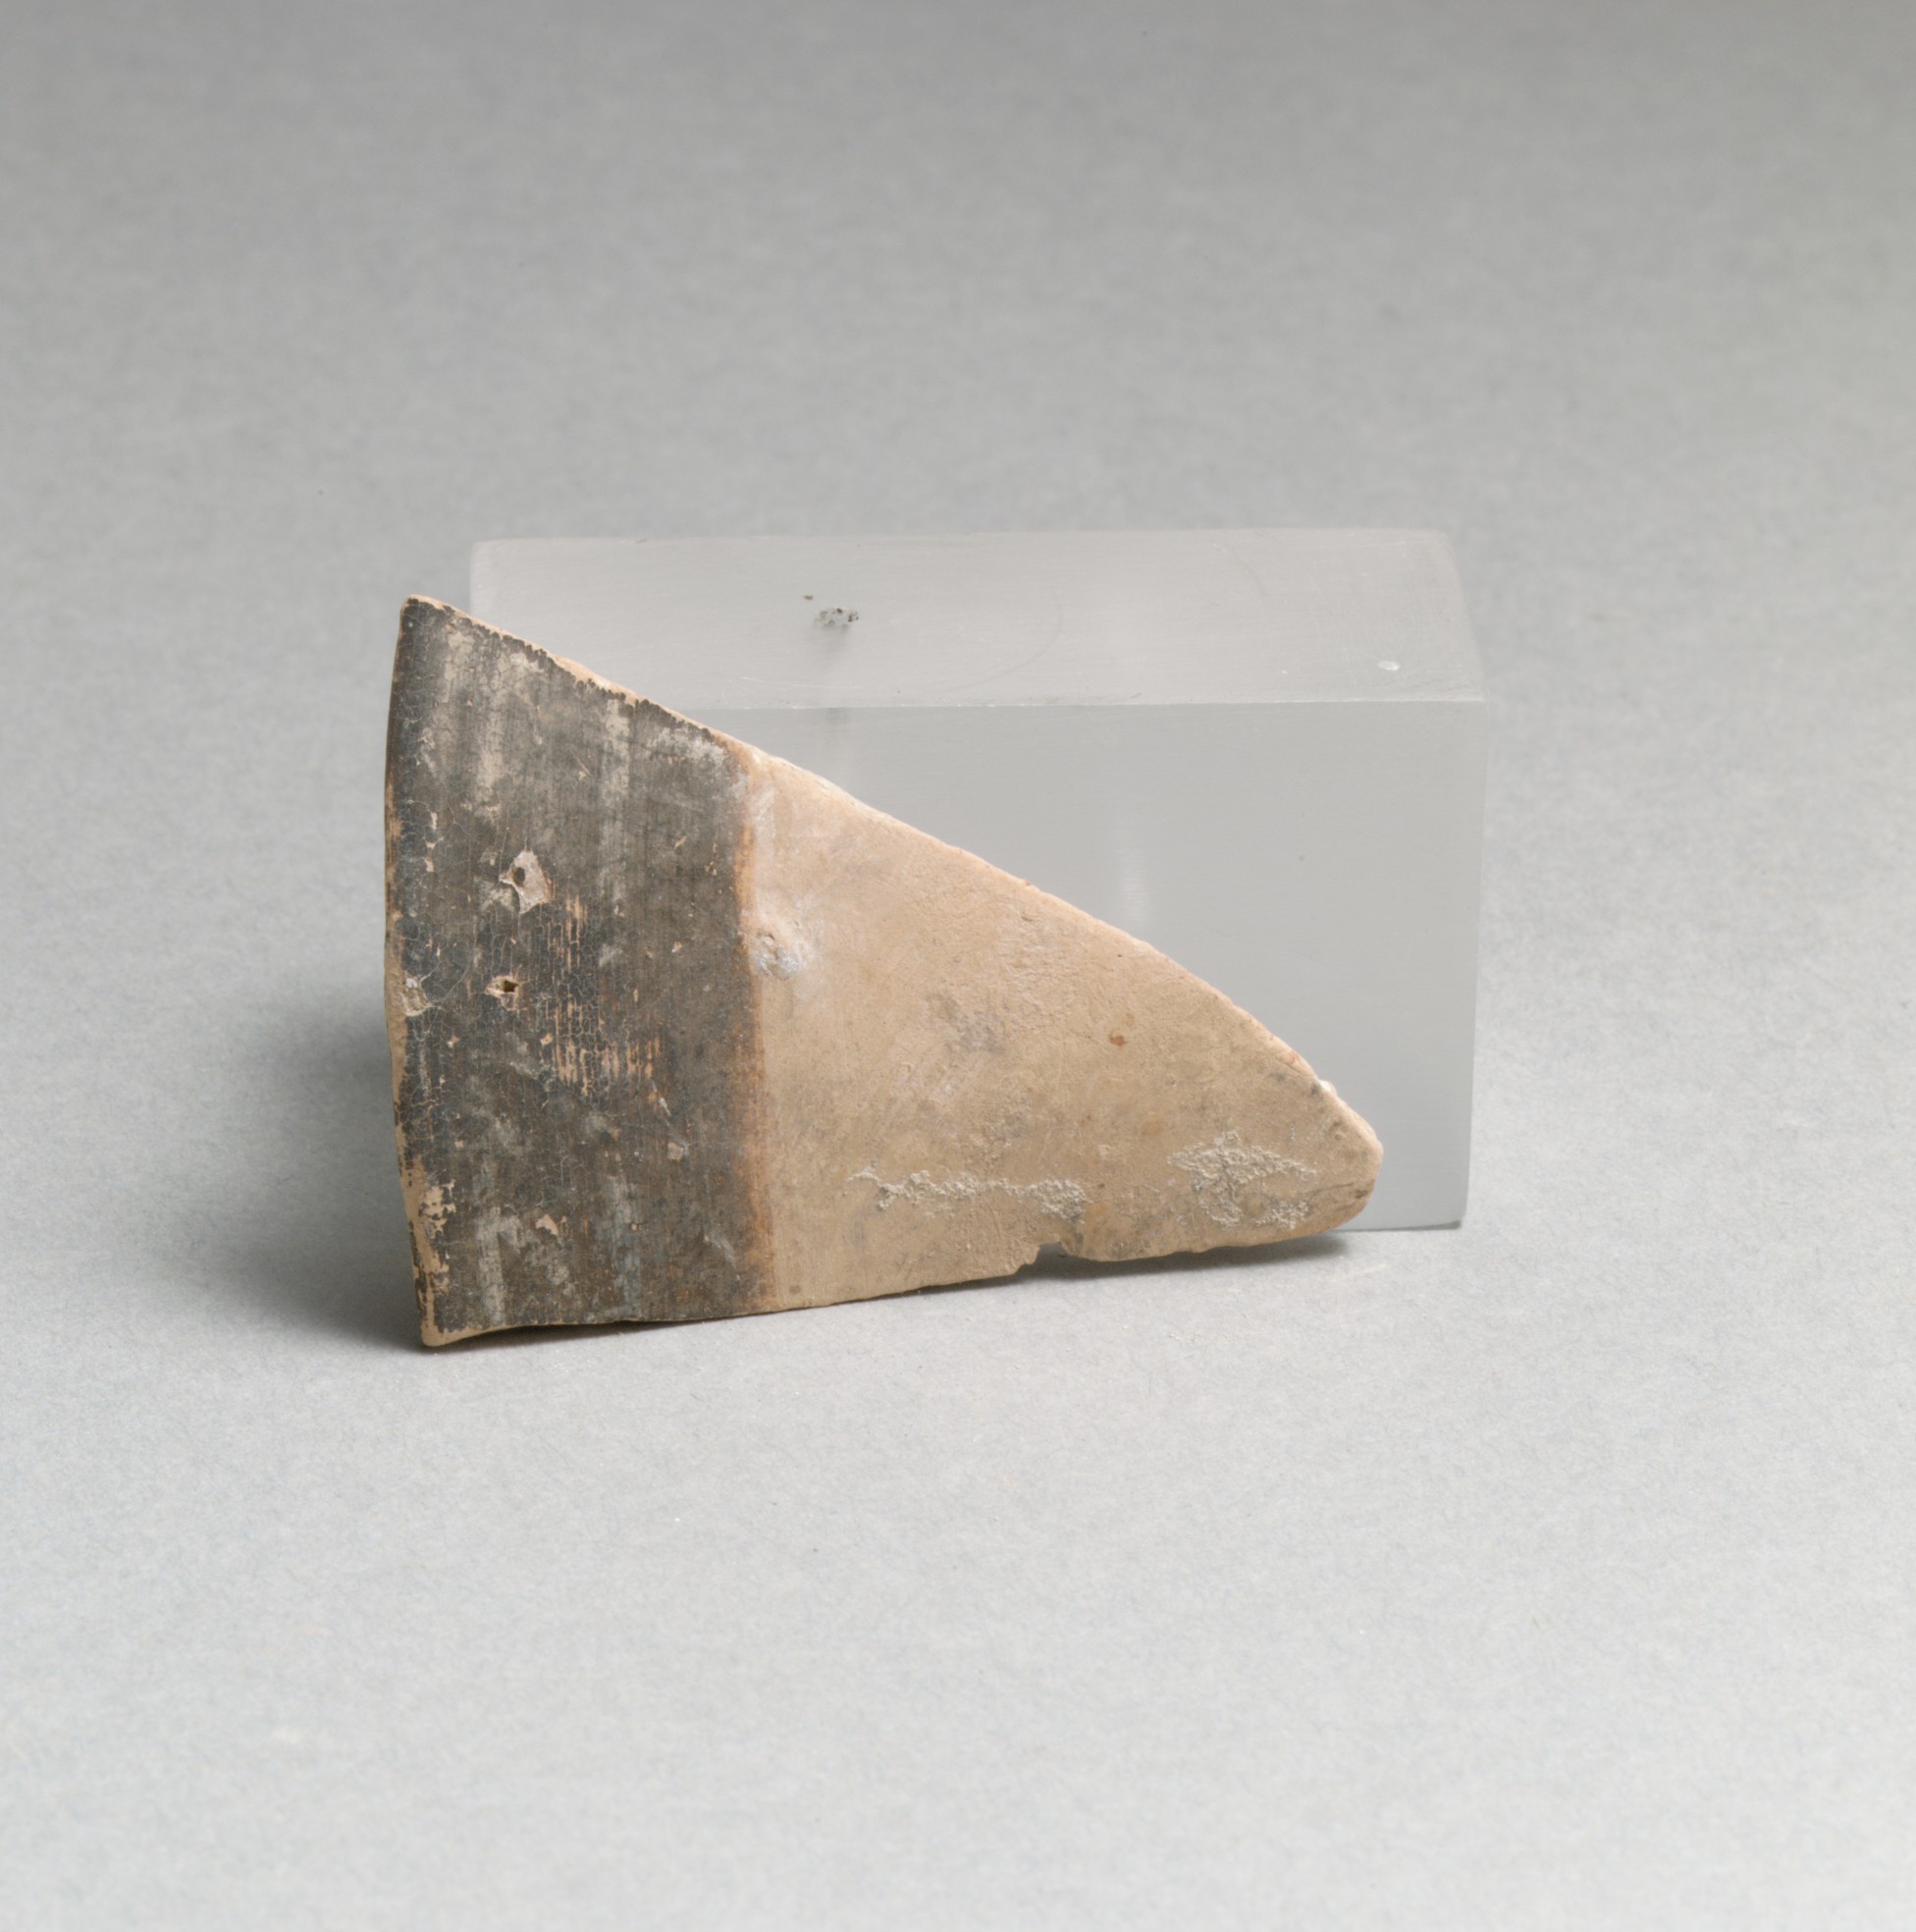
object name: vase fragment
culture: minoan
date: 2600-2000 BCE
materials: terracotta